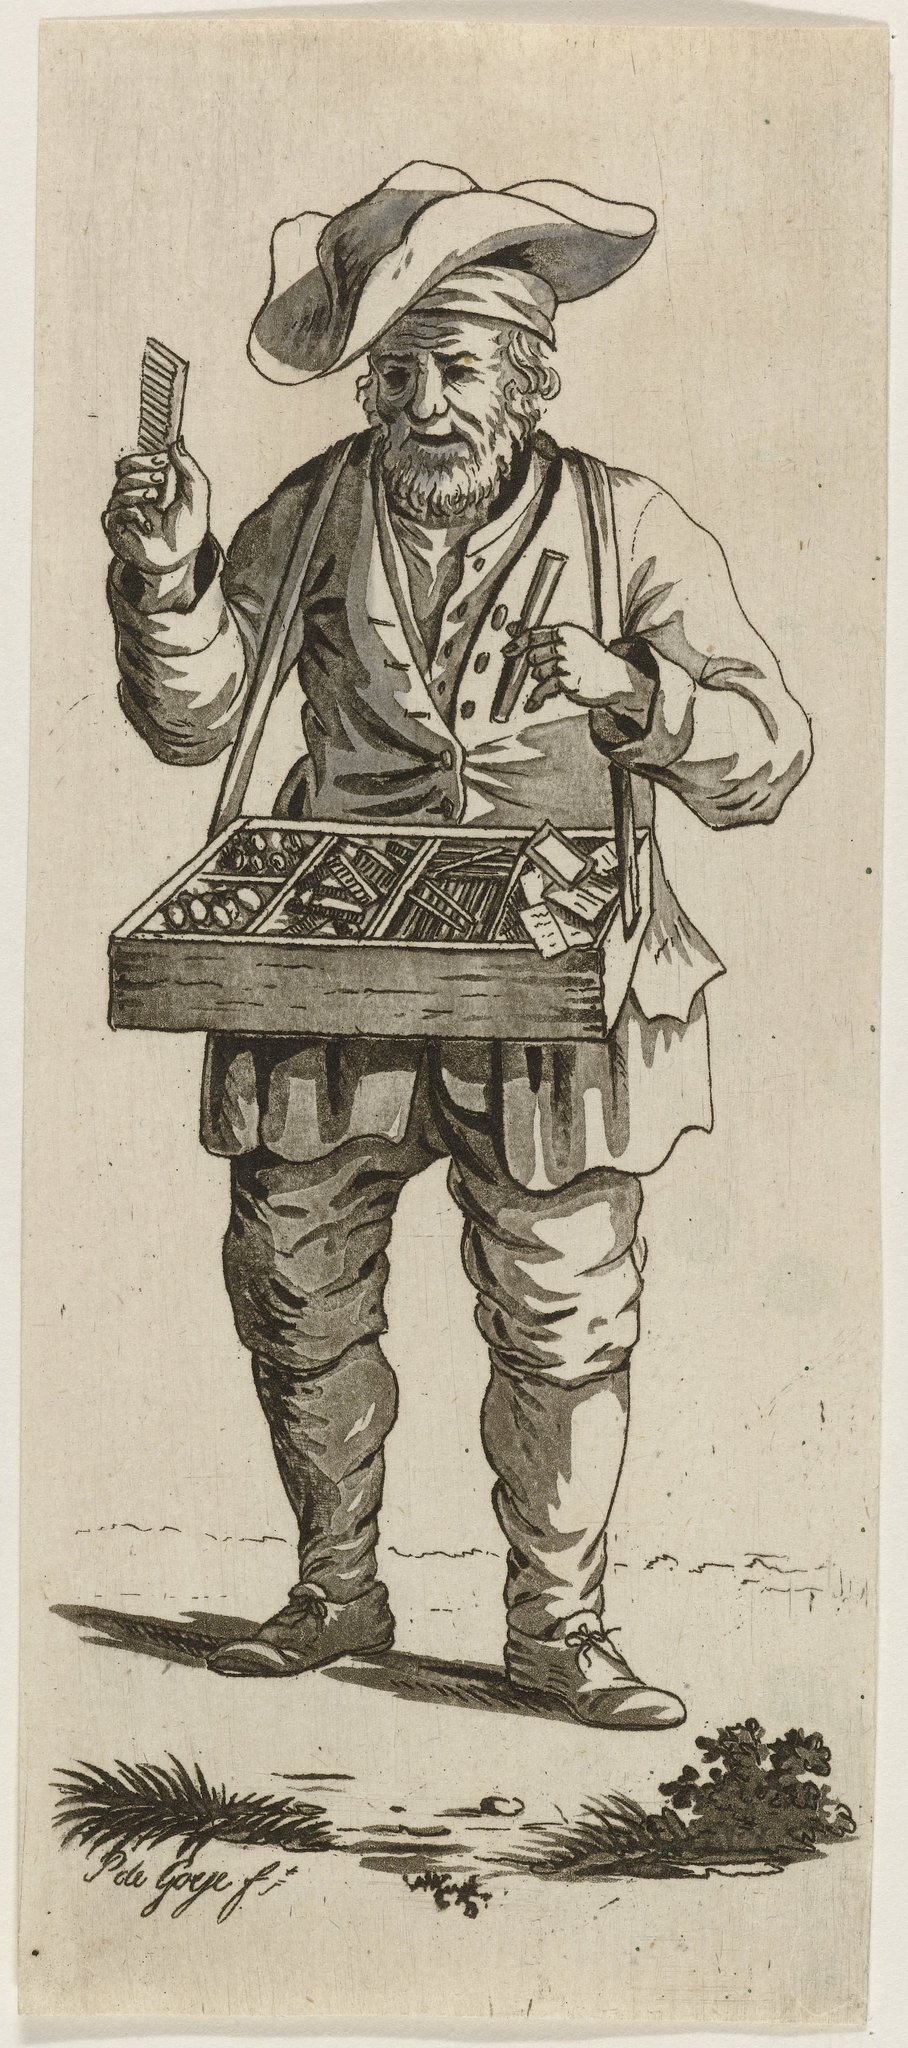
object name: print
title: Marskramer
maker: pieter de goeje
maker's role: draughtsman, print maker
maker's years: 1789-1859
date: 1789-1859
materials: paper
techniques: aquatint, etching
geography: amsterdam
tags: pedlar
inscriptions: collector's mark: Lugt 2228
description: Een marskramer met een grote hoed verkoopt allerlei snuisterijen uit een mars, onder andere kammetjes en spiegeltjes.